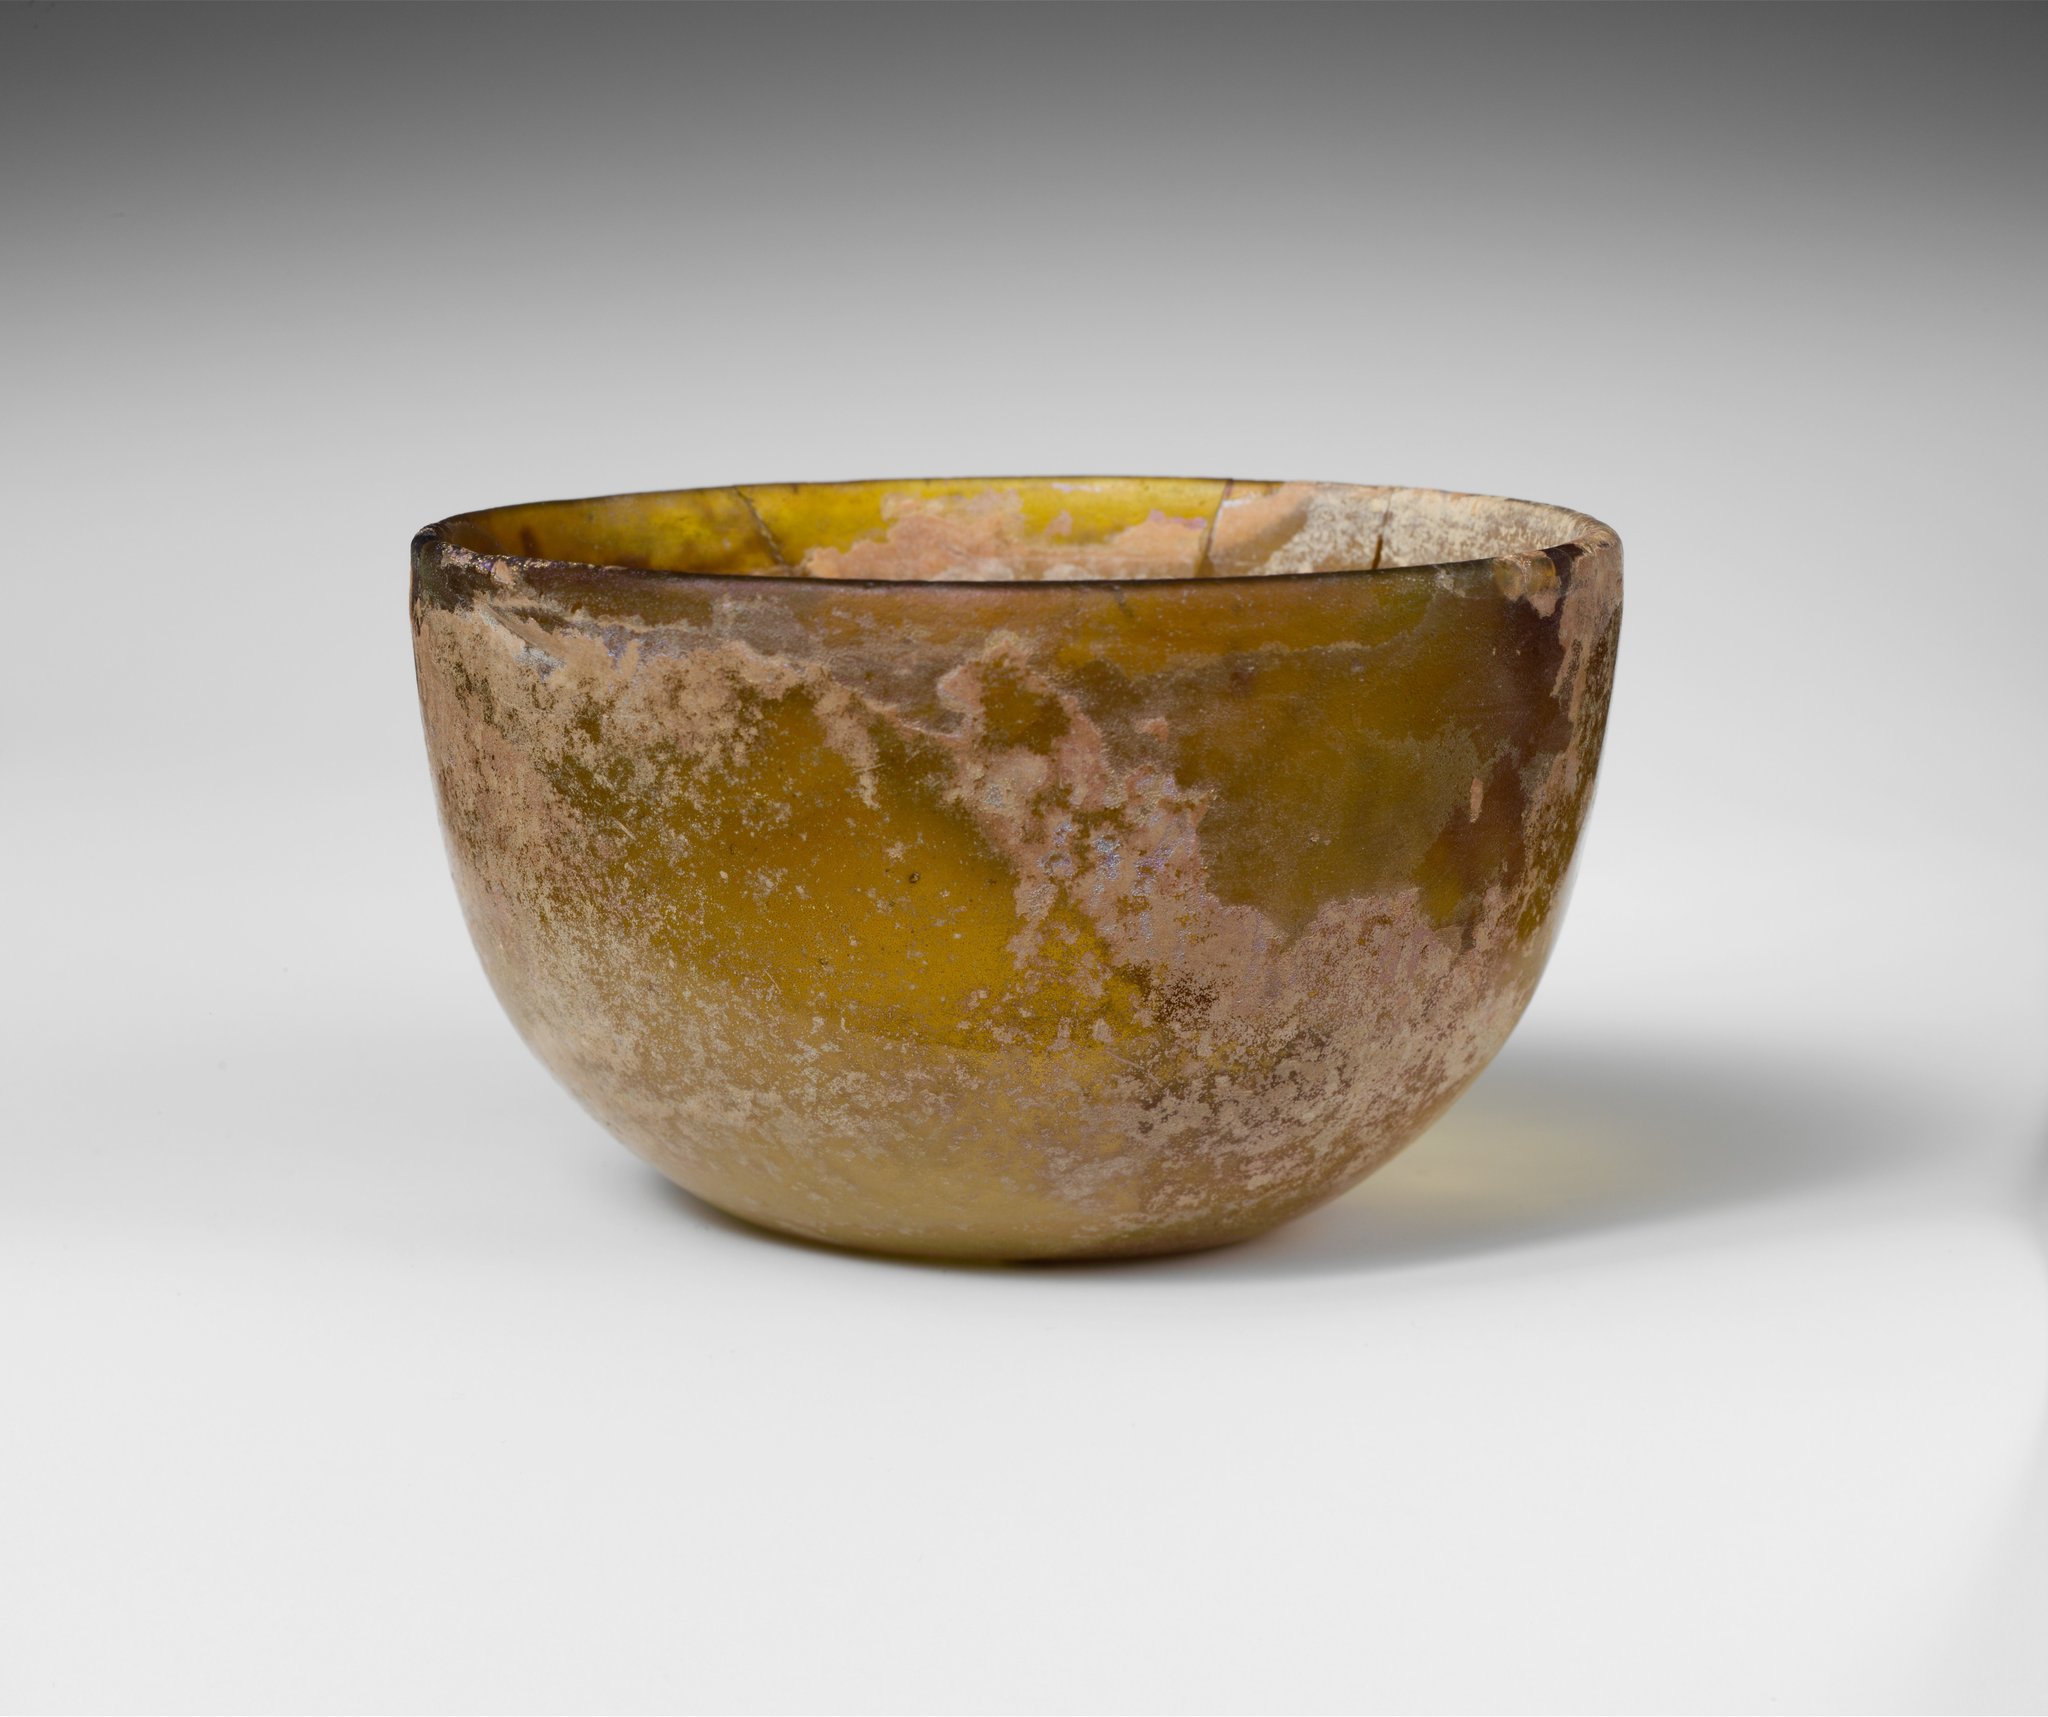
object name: bowl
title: Glass bowl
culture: roman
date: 34 BCE-33 CE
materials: glass